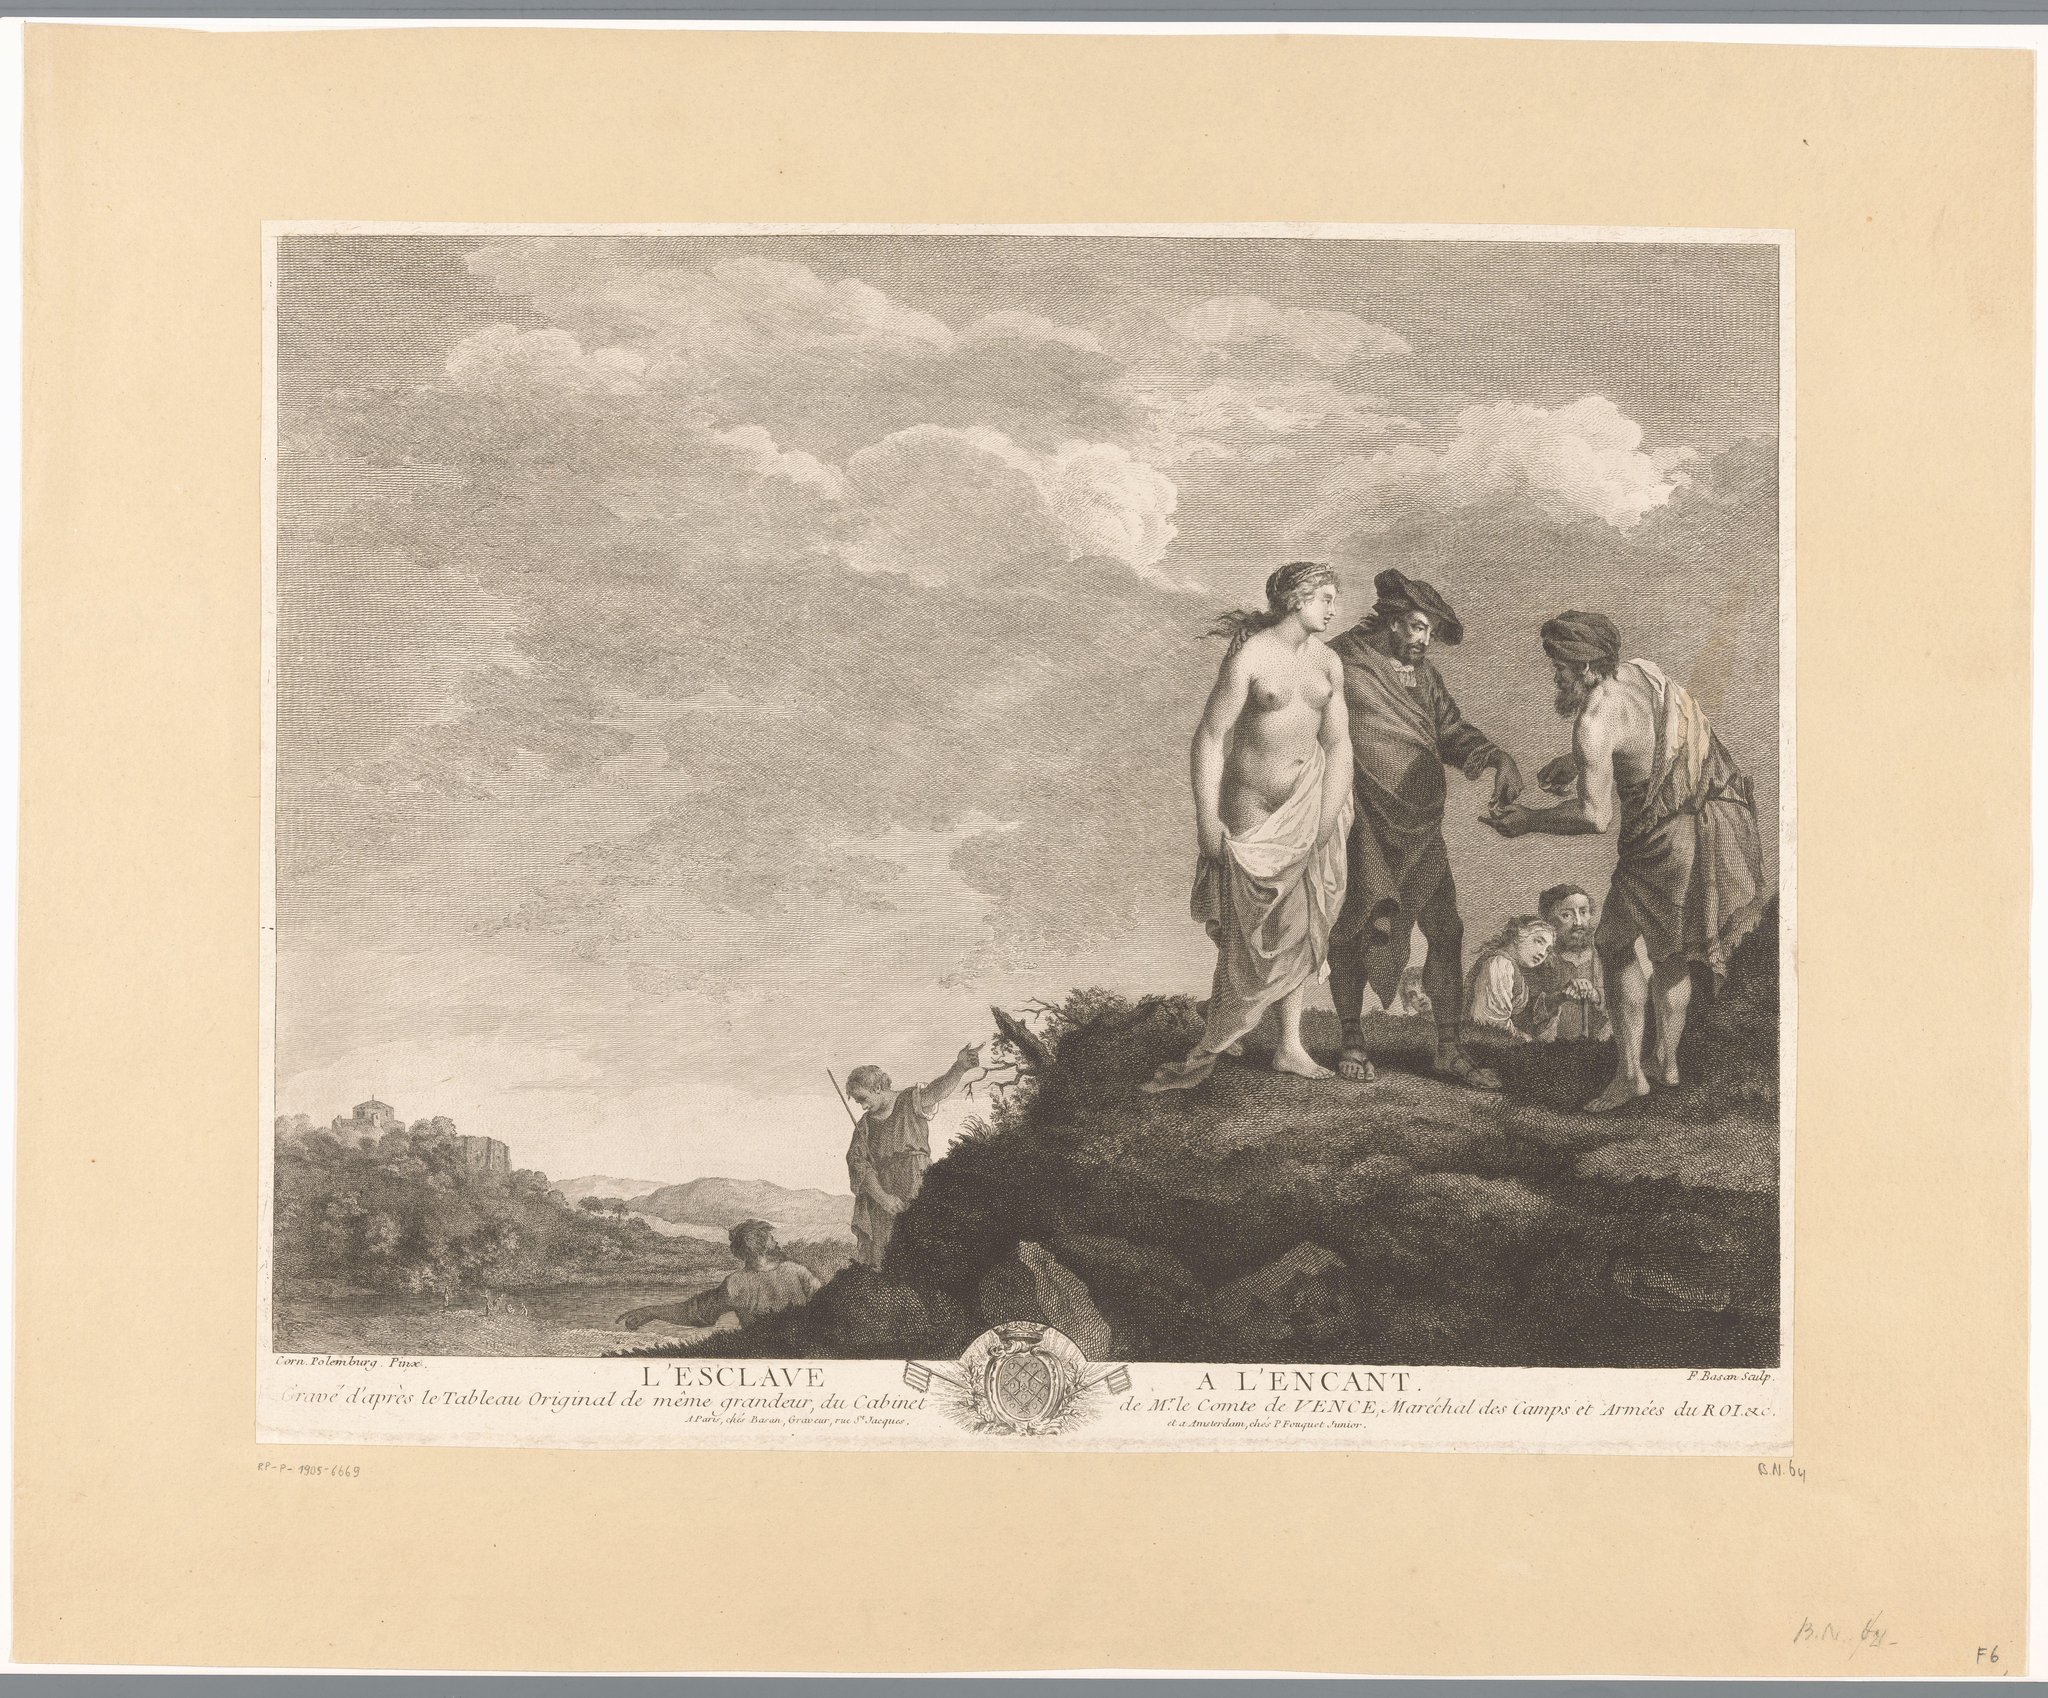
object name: print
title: Slavenveiling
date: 1739-1797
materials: paper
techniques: engraving, etching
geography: paris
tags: slave-trade, slavery; serfs and enslaved persons, armorial bearing, heraldry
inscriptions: collector's mark: Lugt 2228